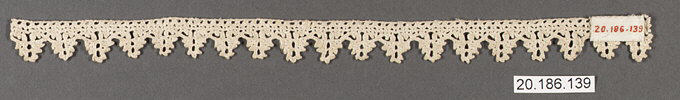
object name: edging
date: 1601-1700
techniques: lace